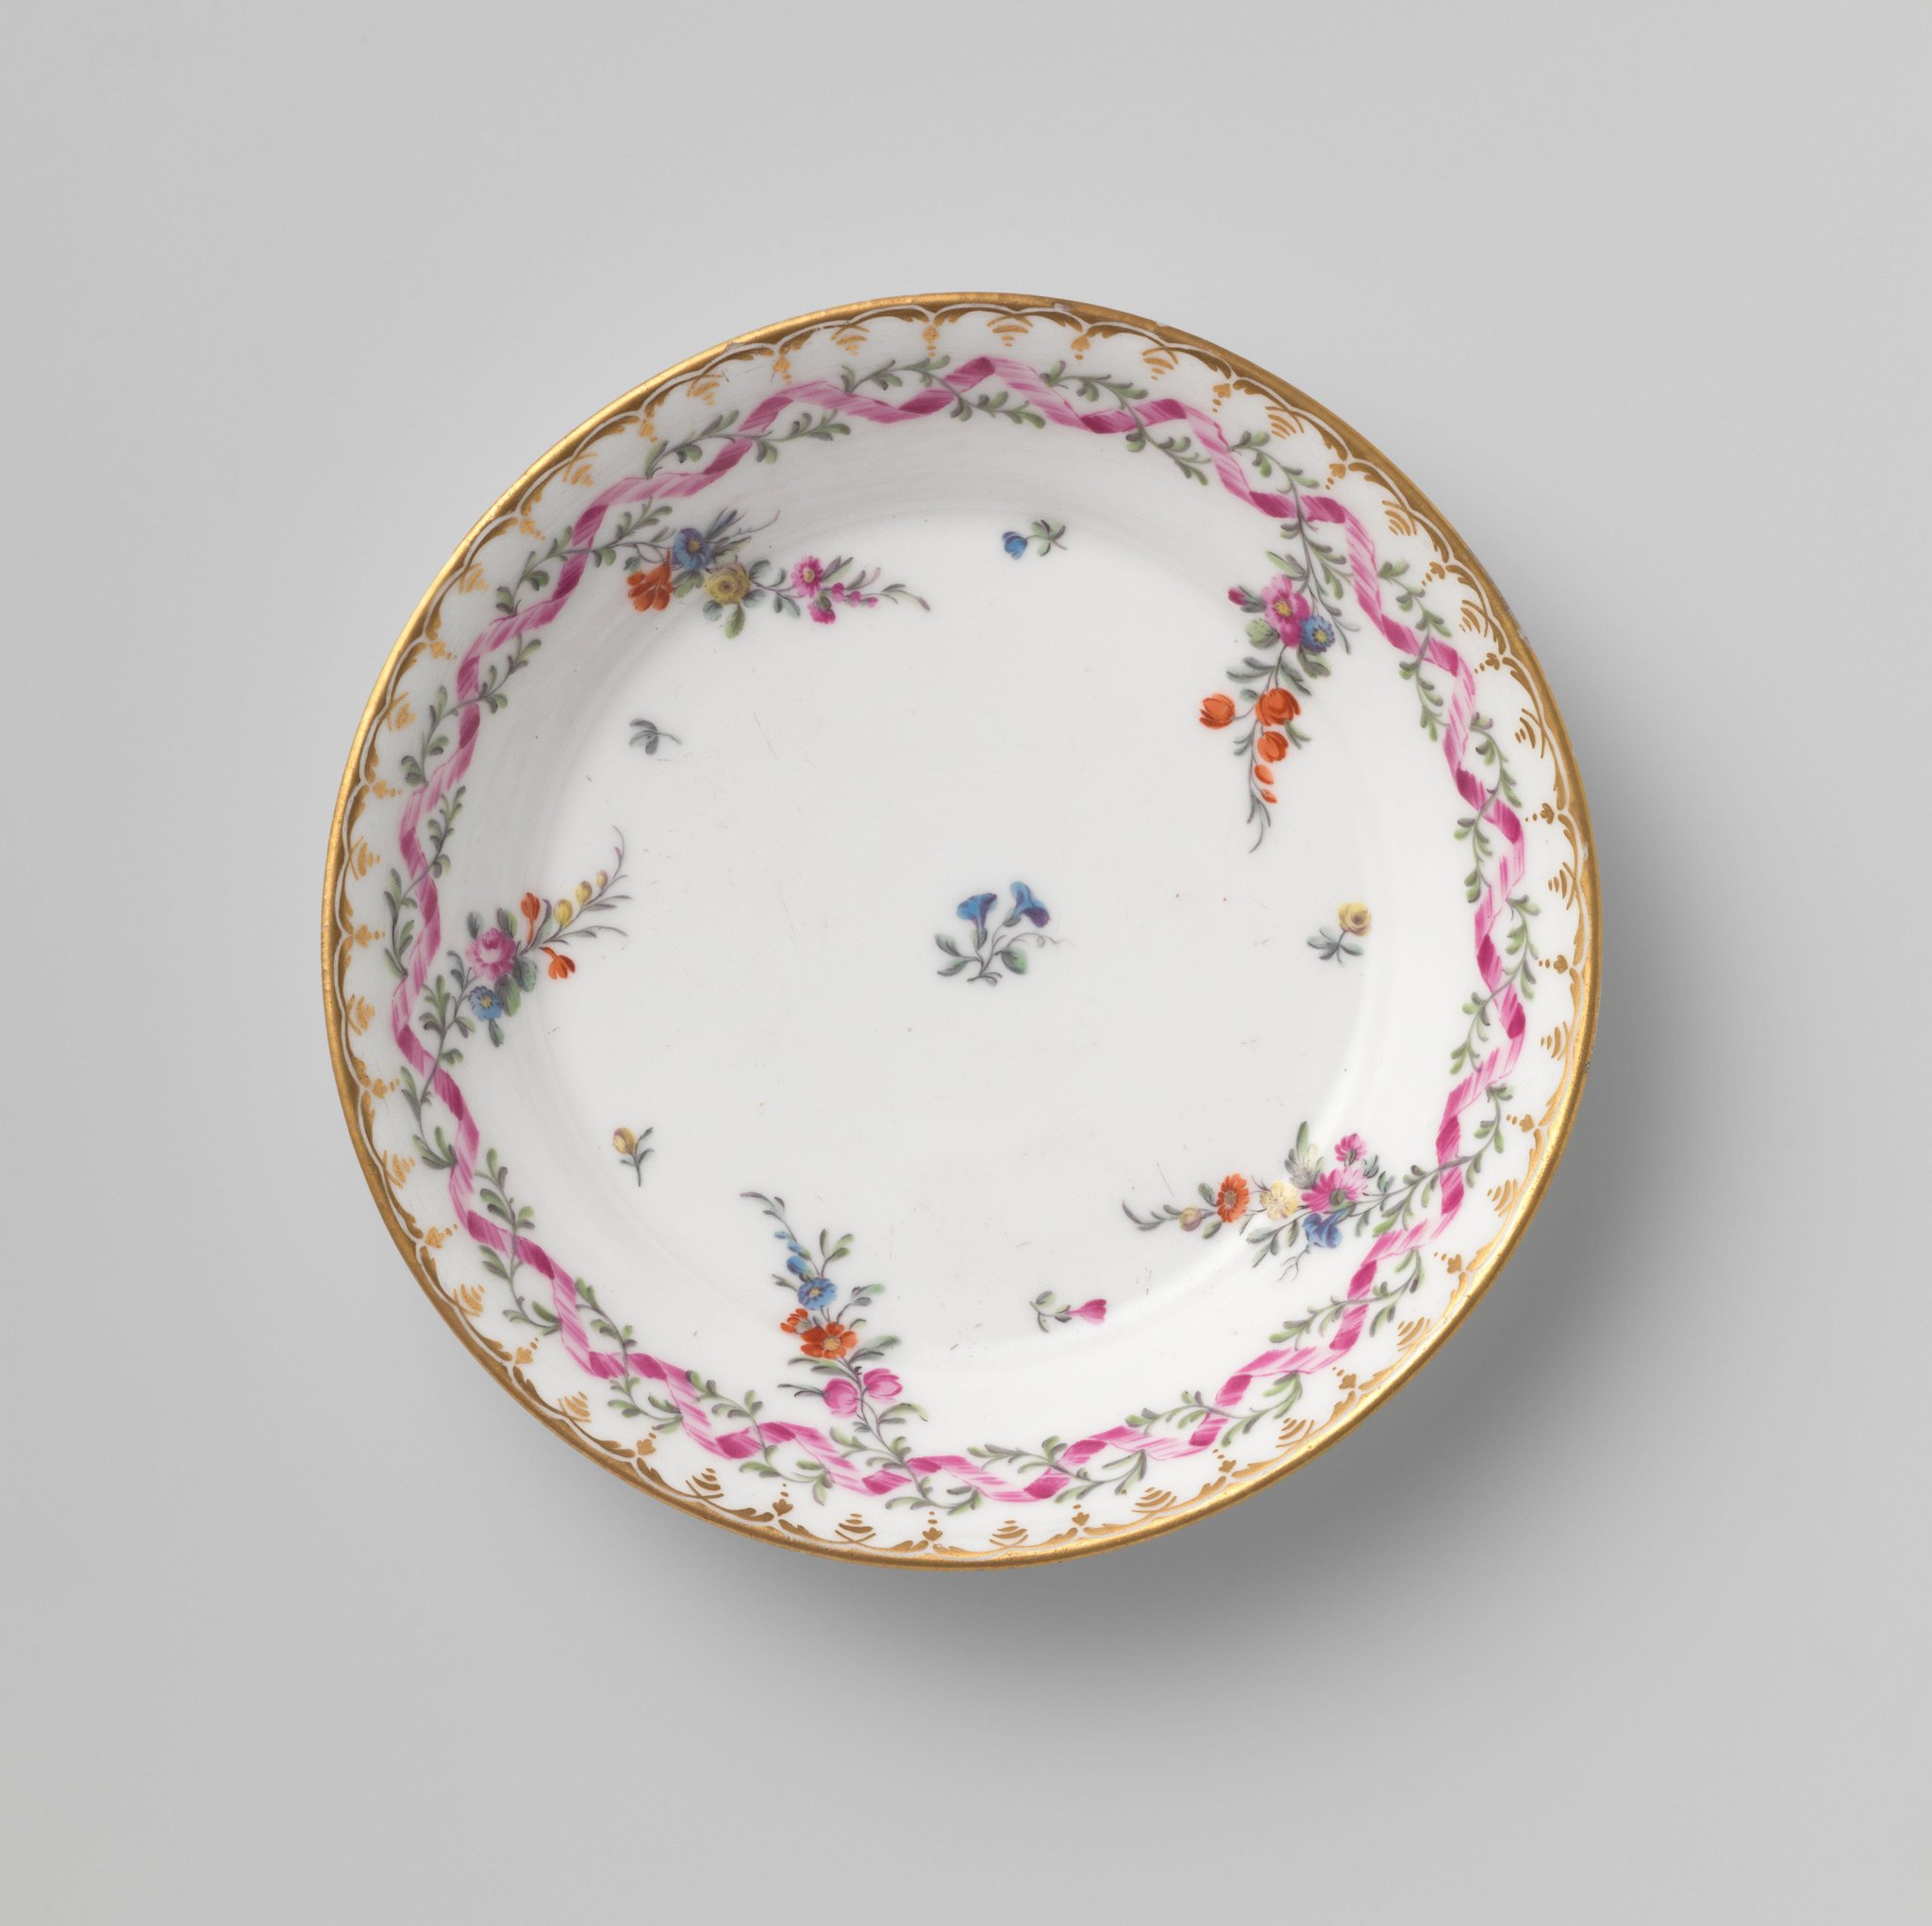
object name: platter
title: Schotel, beschilderd met een zigzaglint, waaromheen een tak met bladeren slingert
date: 1778-1782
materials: porcelain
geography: loosdrecht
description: Coffee cup and saucer. Porcelain. Loosdrecht, c. 1778 - 1782. Factory of Joannes de Mol.